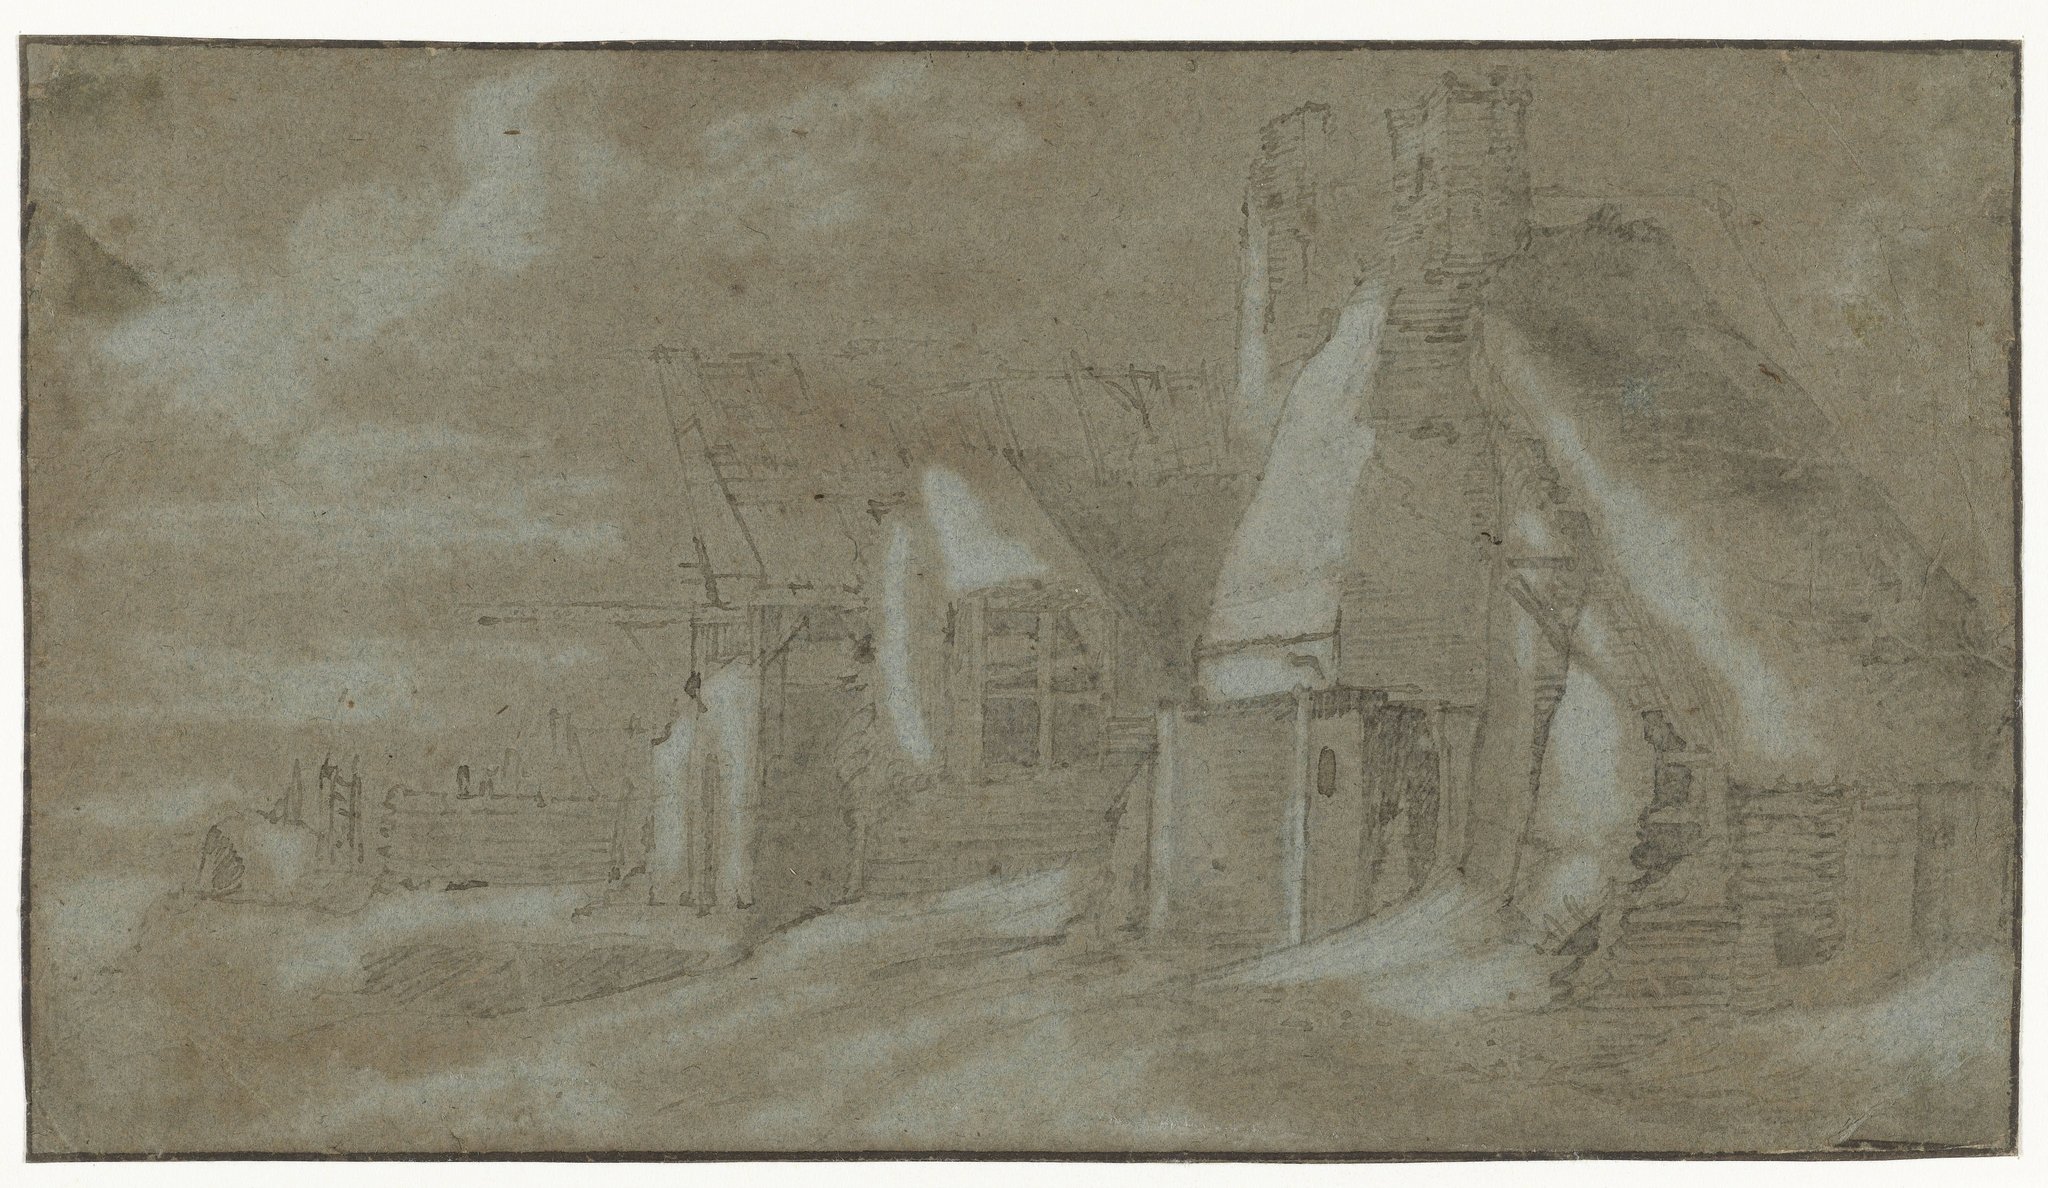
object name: drawing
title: Vervallen boerderijen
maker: Anonymous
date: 1600-1699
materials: ink, paper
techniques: brush, pen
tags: ruin of a building ~ architecture, farm (building)